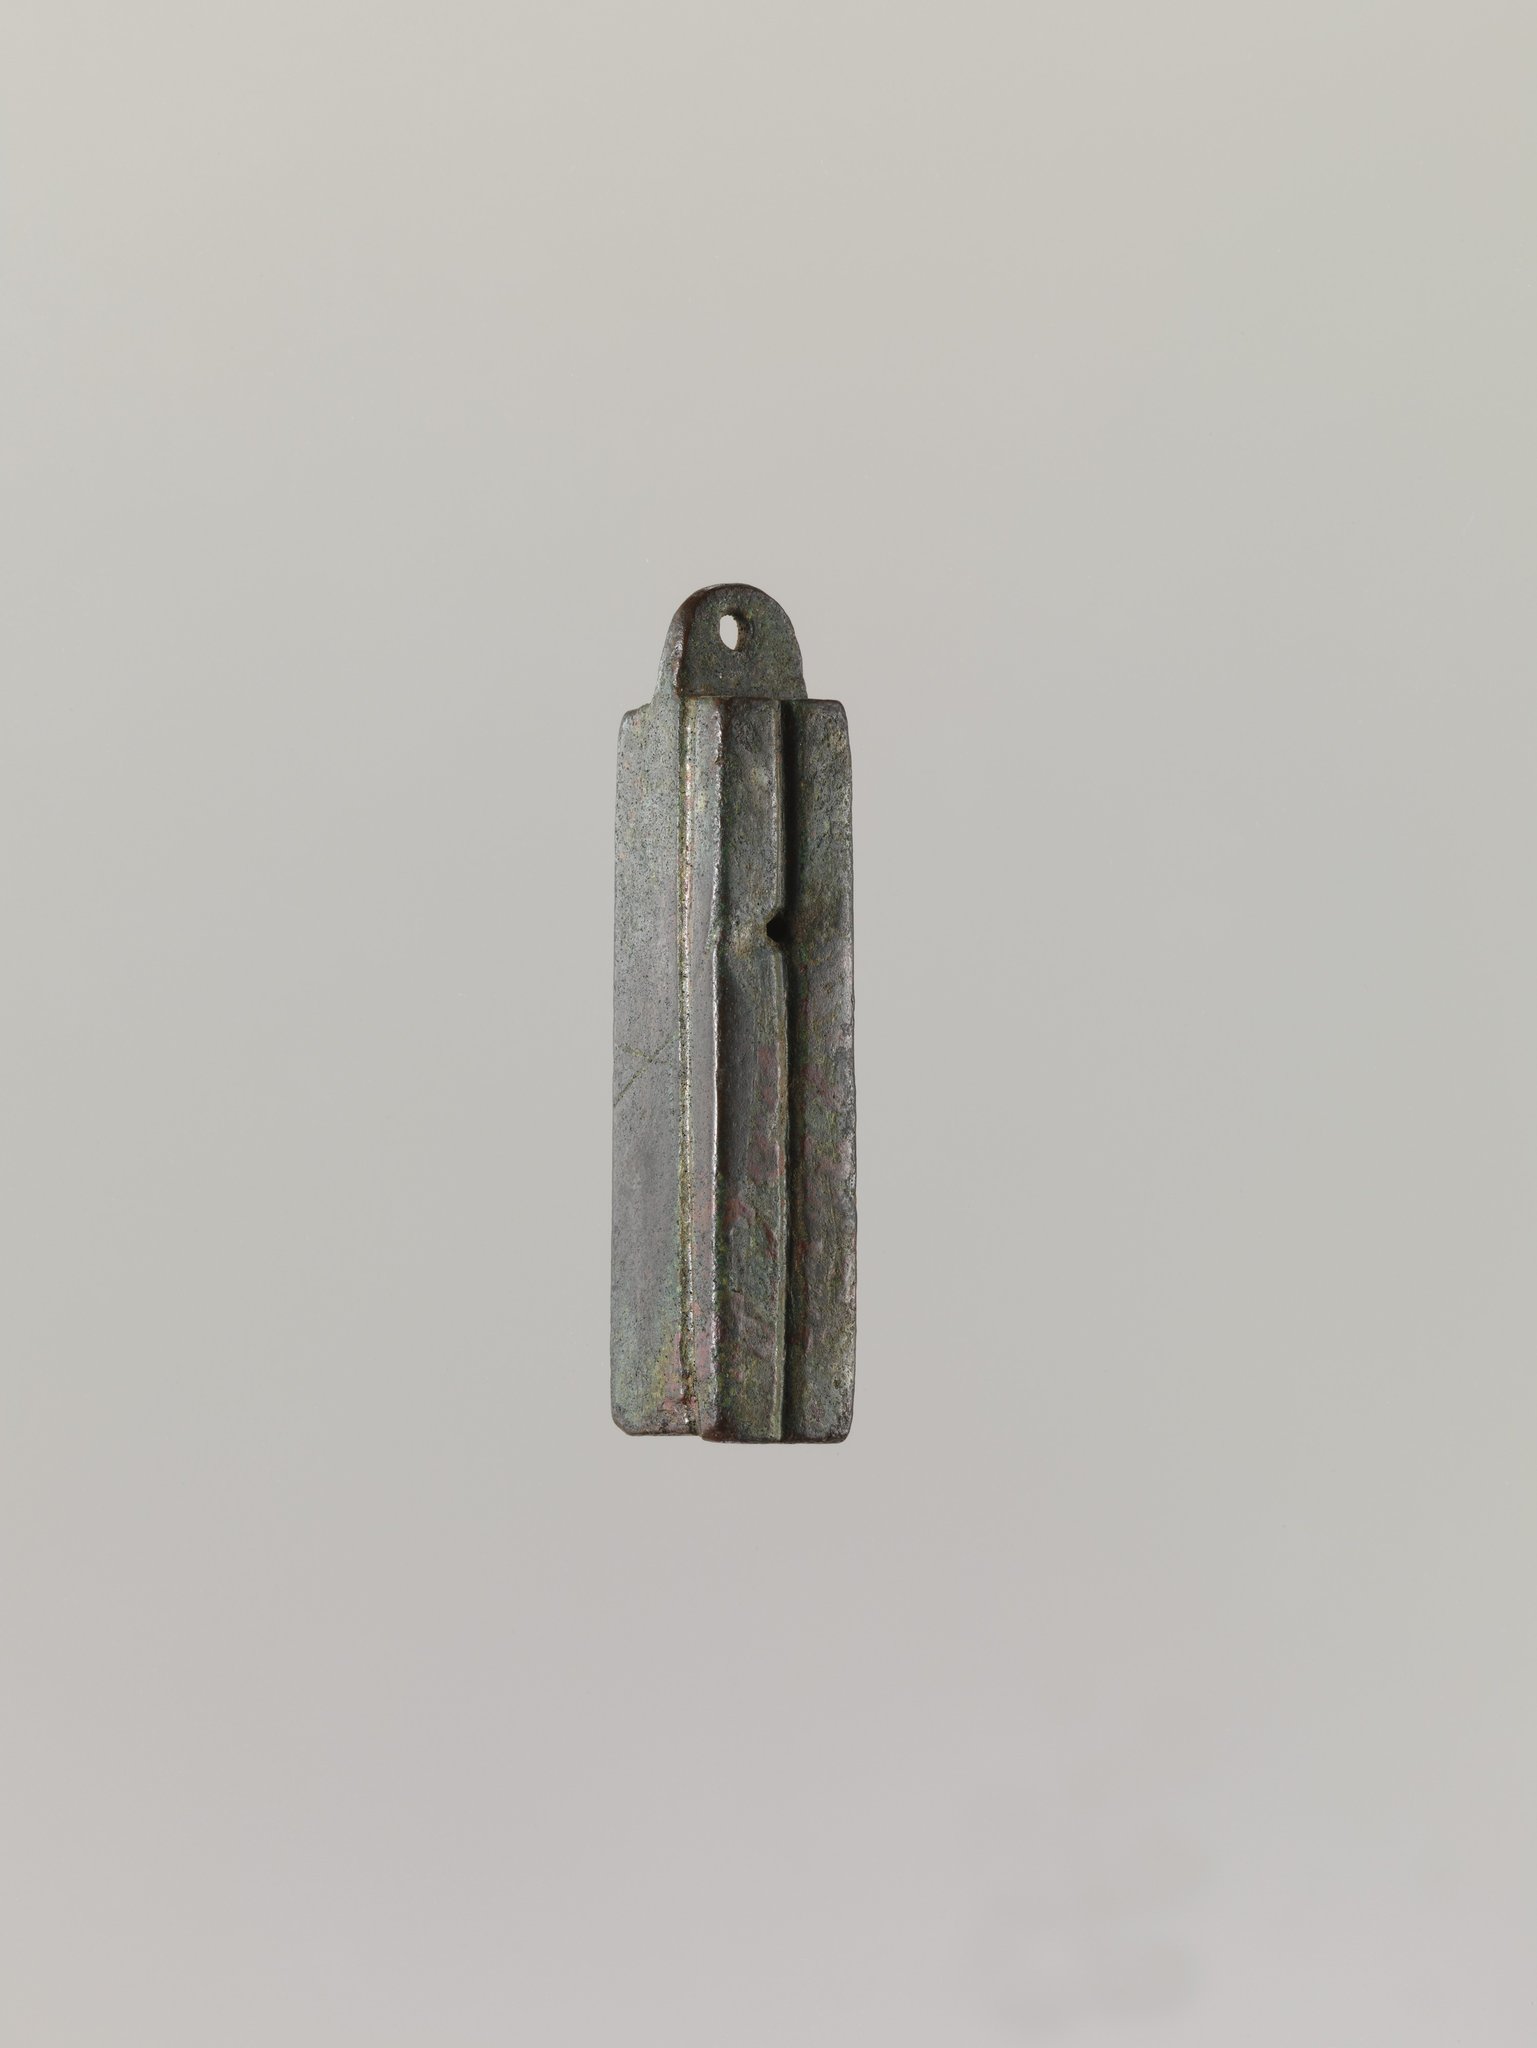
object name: coin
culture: chinese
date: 206 BCE-220 CE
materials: bronze